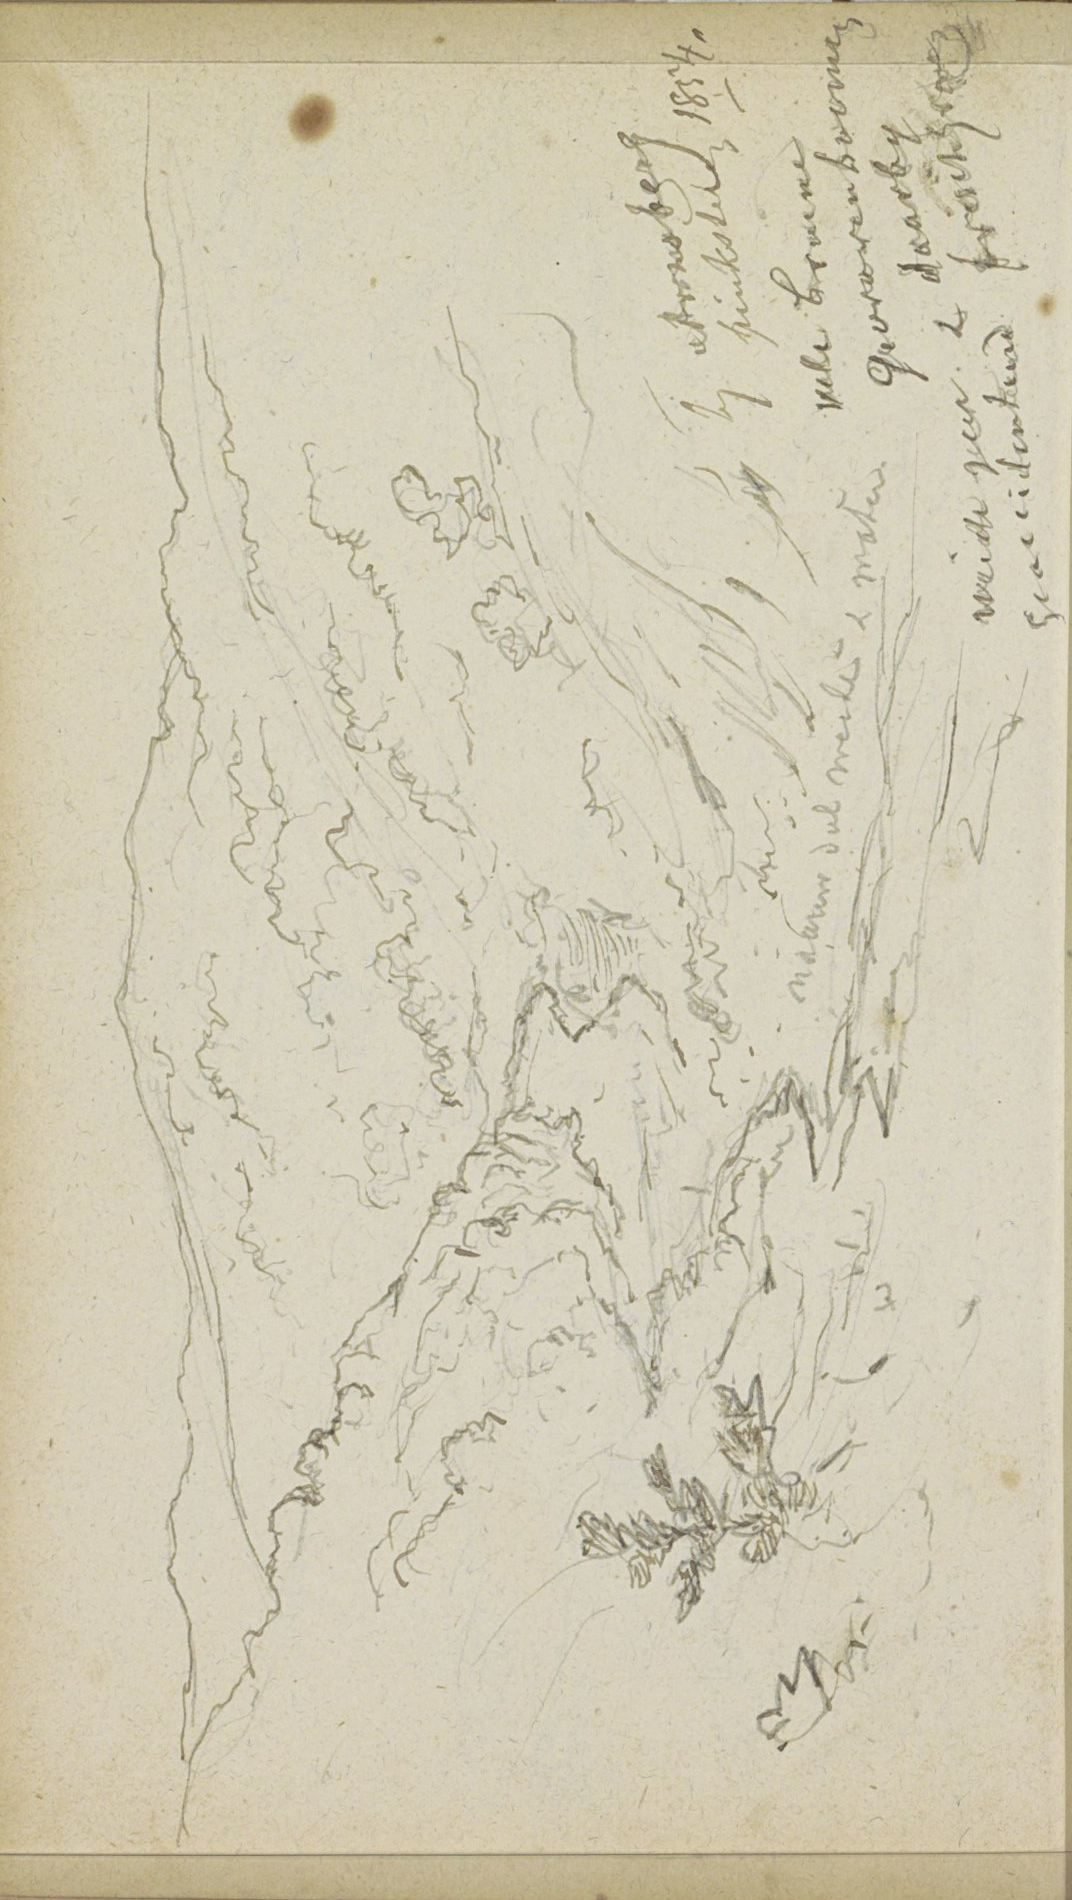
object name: sketchbook leaf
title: Rivierdal van de Ruhr bij Arnsberg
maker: johannes tavenraat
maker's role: draughtsman, painter, print maker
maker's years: 1809-1881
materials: ink, paper, pencil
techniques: pen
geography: arnsberg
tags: dale, valley, landscapes with waters, waterscapes, seascapes (in the temperate zone)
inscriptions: date and inscription: ‘bij Arnsberg/ pinksteren 1854.’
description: Blad 25 verso uit een schetsboek met 88 bladen.